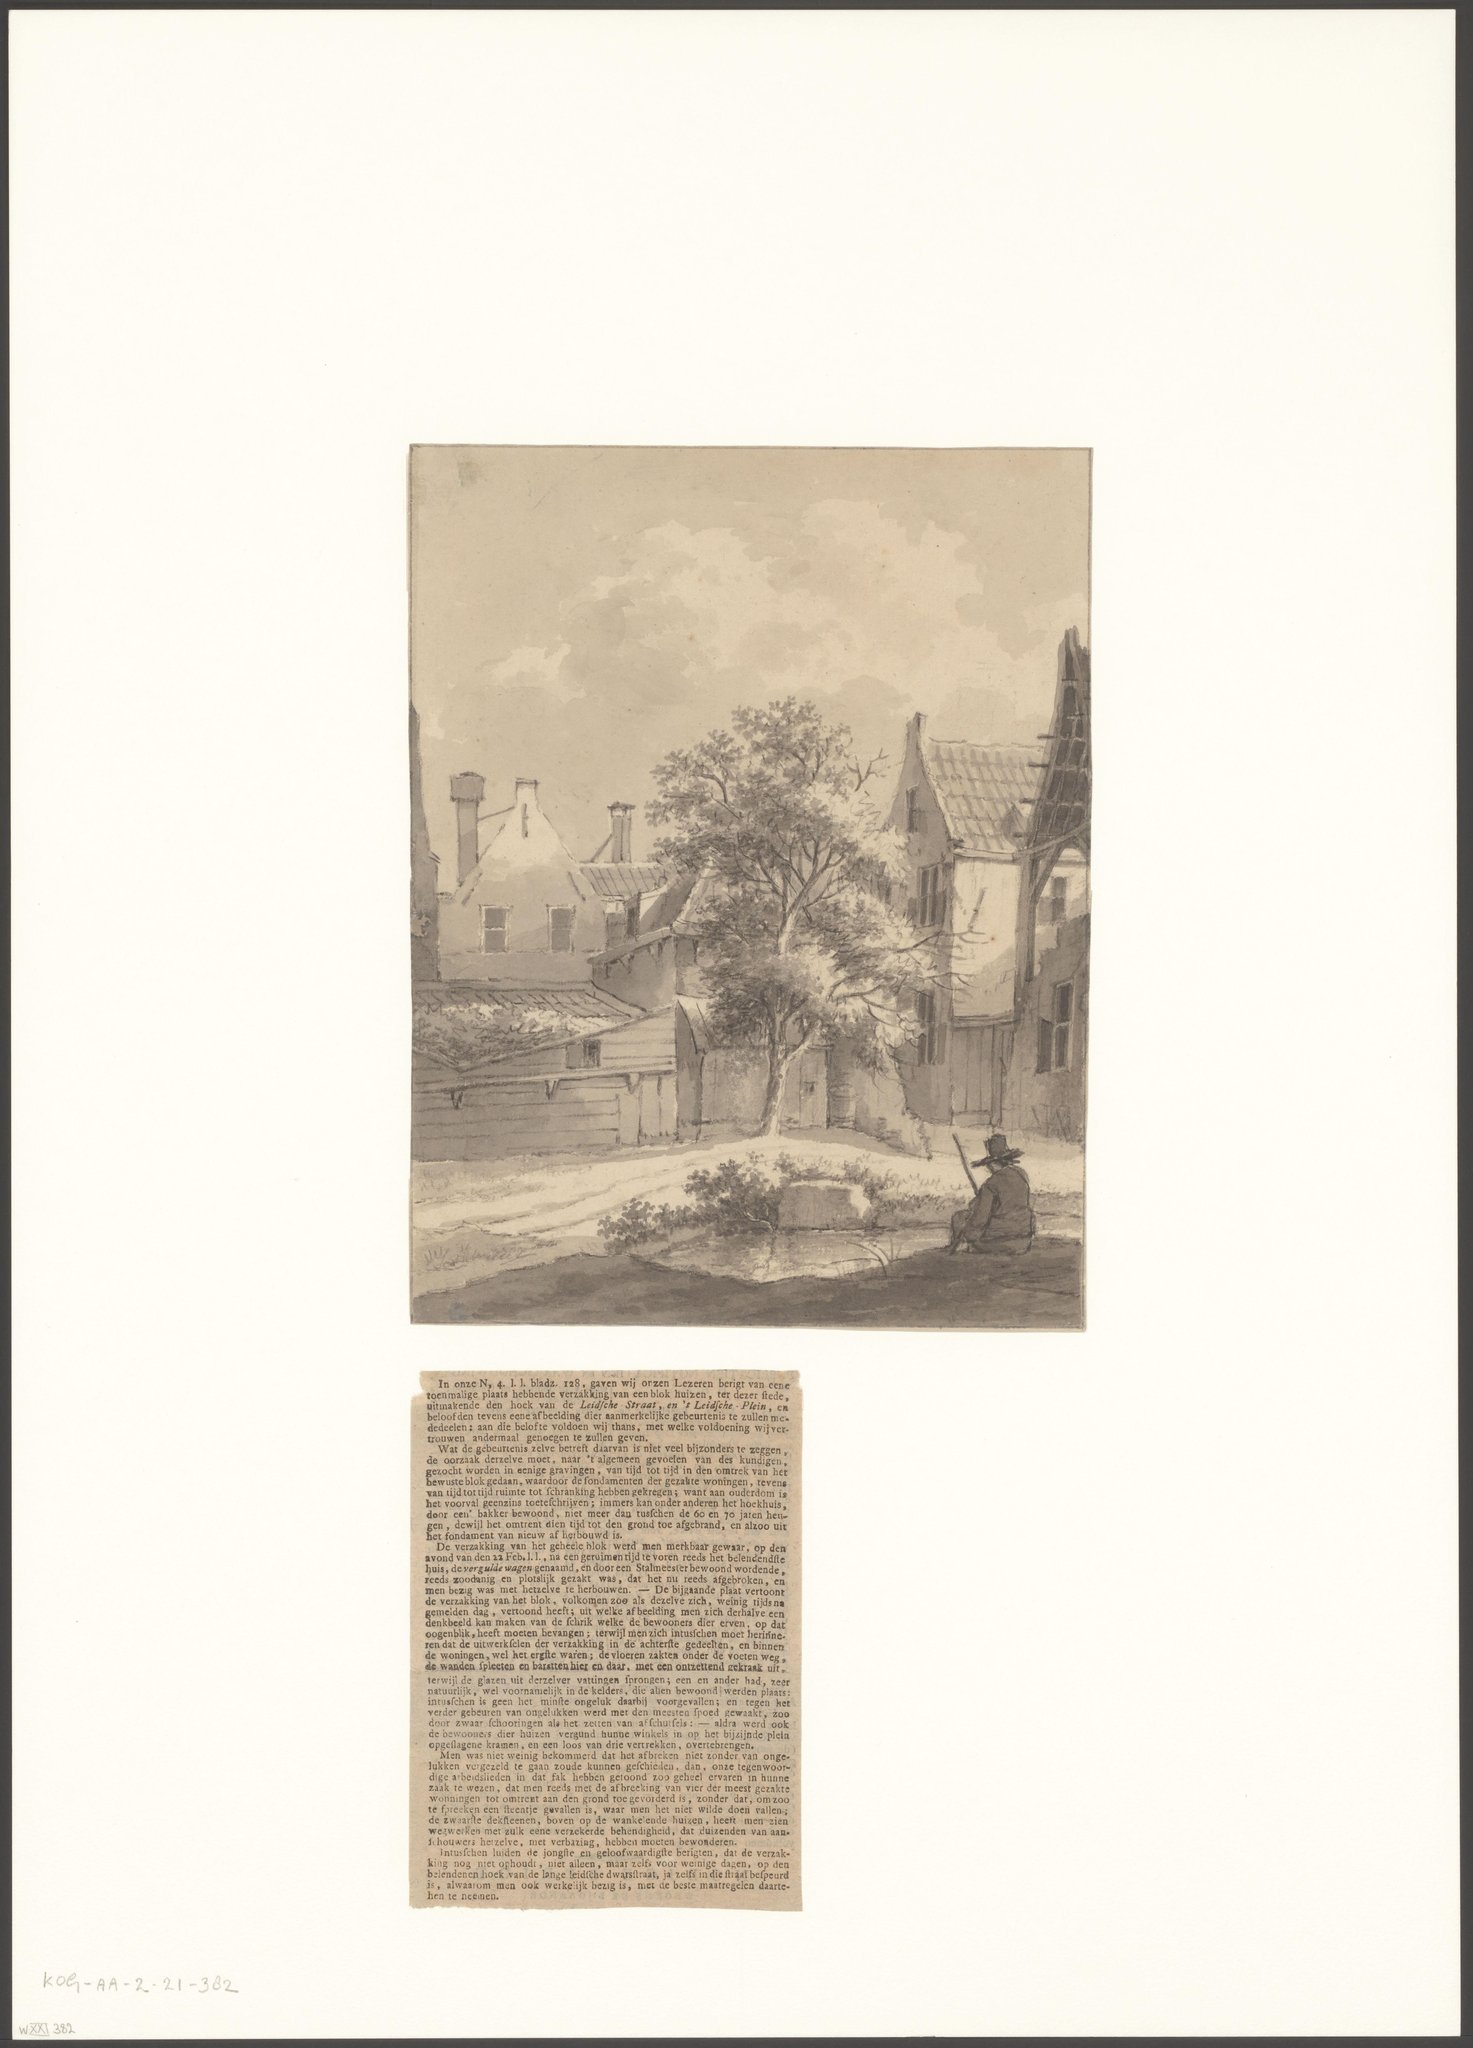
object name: drawing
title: Gezicht op enkele verzakte huizen aan de Leidsestraat, hoek Leidseplein met een krantenbericht over de inzakking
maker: daniël kerkhoff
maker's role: draughtsman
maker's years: 1766-1821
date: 1806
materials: chalk, ink, paper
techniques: brush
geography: amsterdam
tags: city-view in general; 'veduta', collapsing building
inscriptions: collector's mark: Lugt 800a, inscription: ‘[...] de ingesakten Huyzen / op de Lydsestraat. D. Kerkhoff’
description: Tekening binnen de Atlas Van Eck ingedeeld op wijknummer 21.